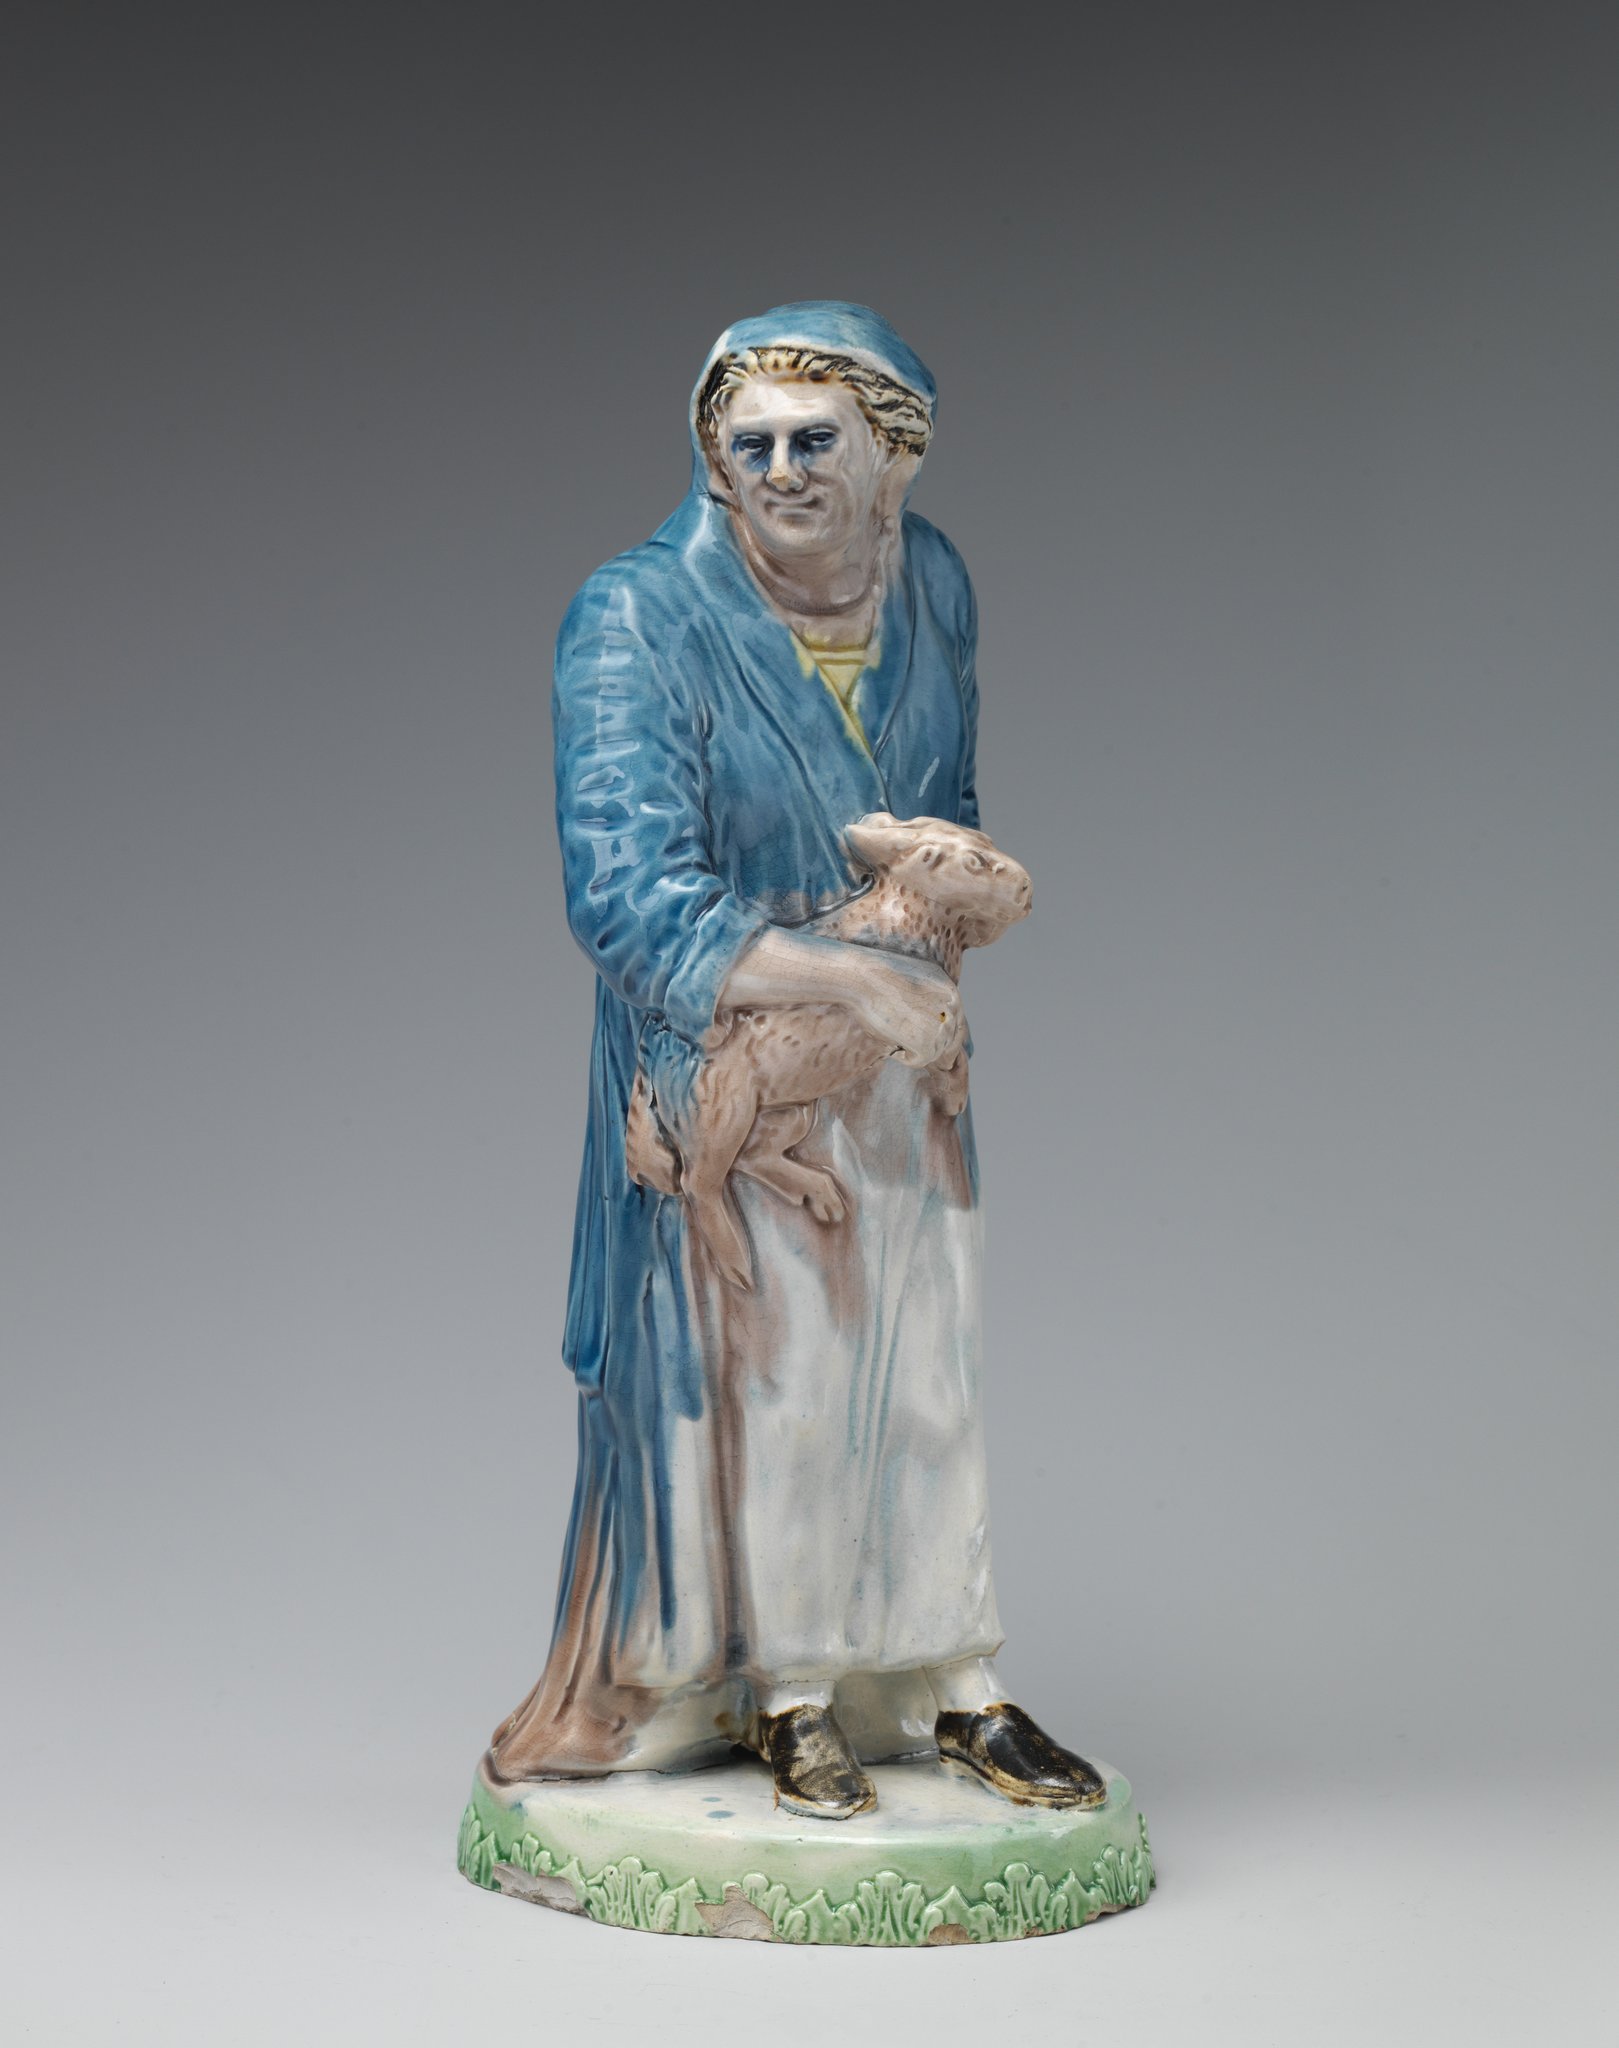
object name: figure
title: Farmer's wife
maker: ralph wood the elder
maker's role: maker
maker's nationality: british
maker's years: 1715-1772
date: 1820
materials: earthenware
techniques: glazing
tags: men,women,sheep,farmers